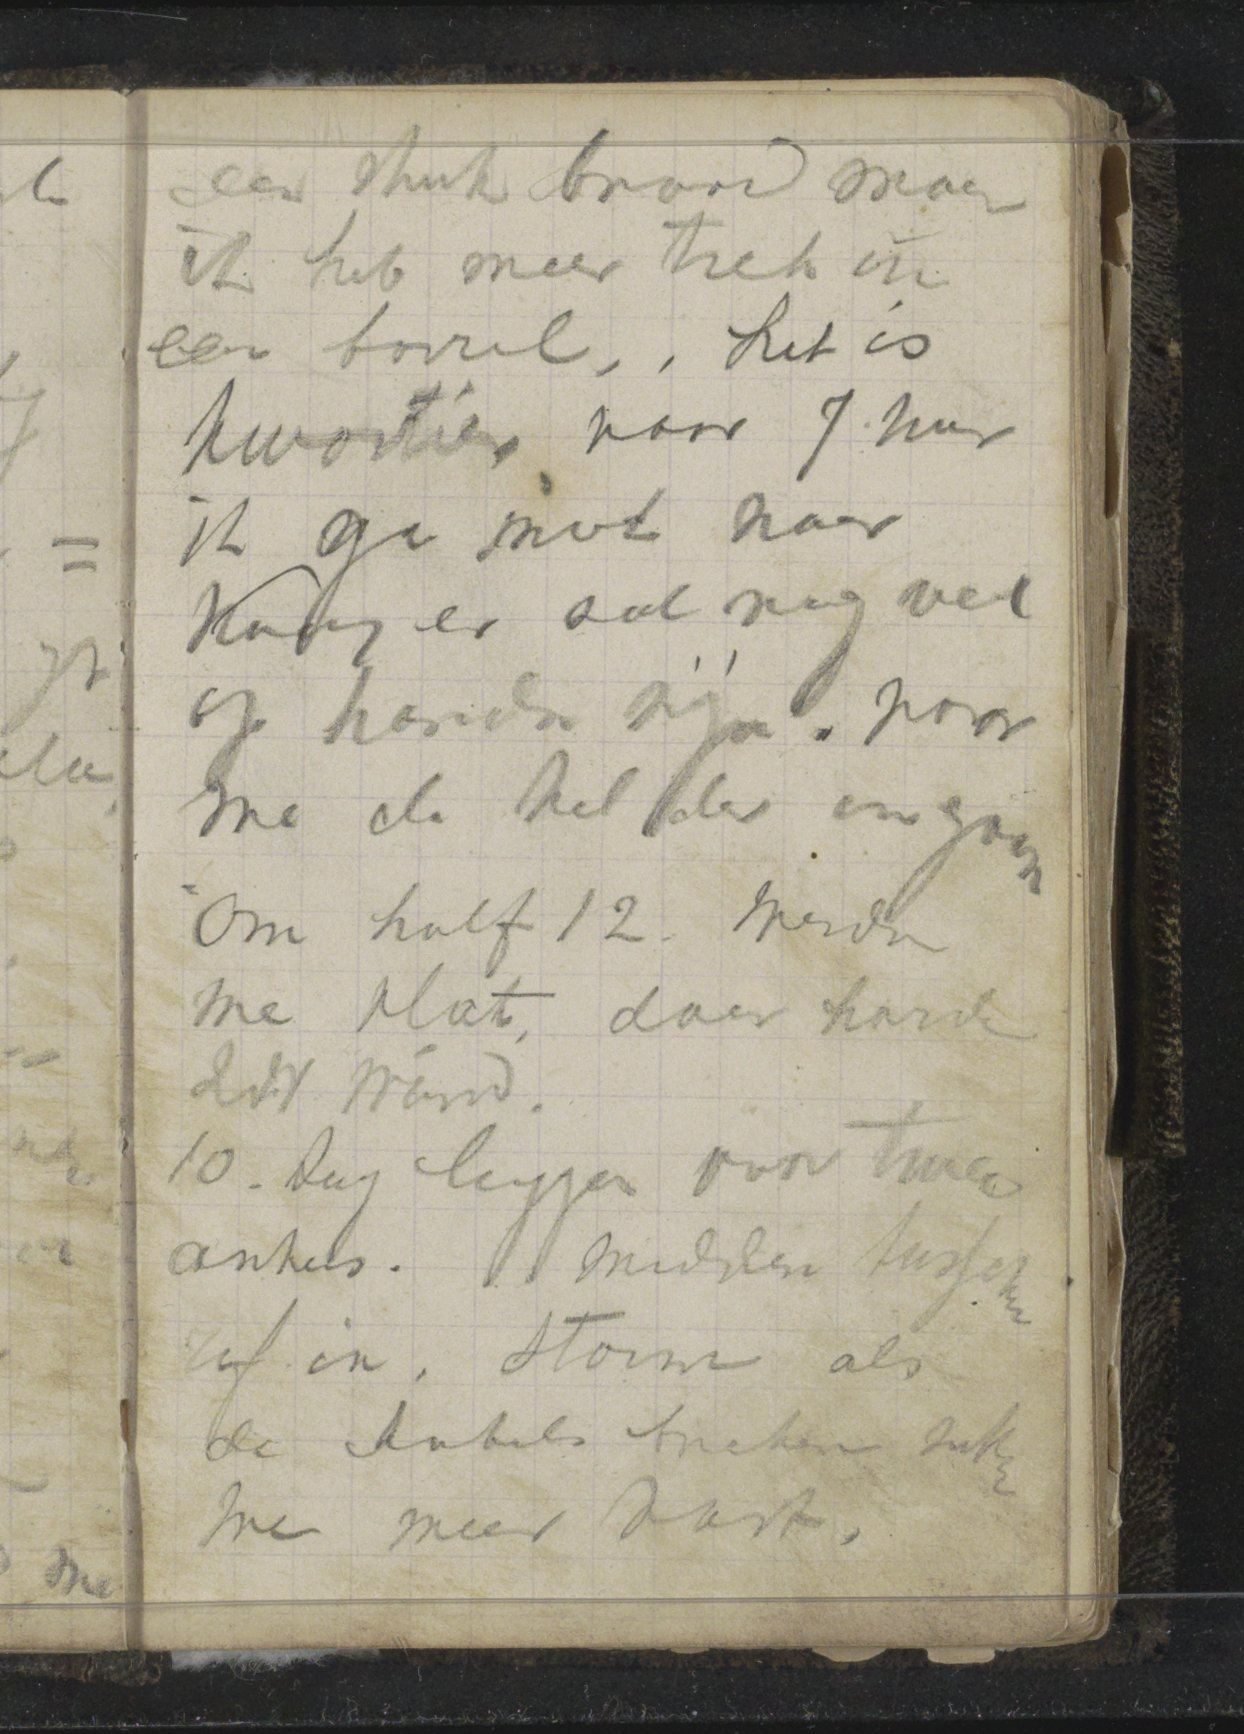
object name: sketchbook leaf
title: Reisverslag van begin augustus 1880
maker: louis apol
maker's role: draughtsman, painter, print maker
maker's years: 1850-1936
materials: pencil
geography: barentsz sea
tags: nova zembla expedities 1880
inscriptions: annotation: ‘een stuk brood maar / ik heb meer trek in / een borrel [...]’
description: Blad 28 recto uit een schetsboek met 110 bladen betekend tijdens de expeditie naar Nova Zembla in 1880.